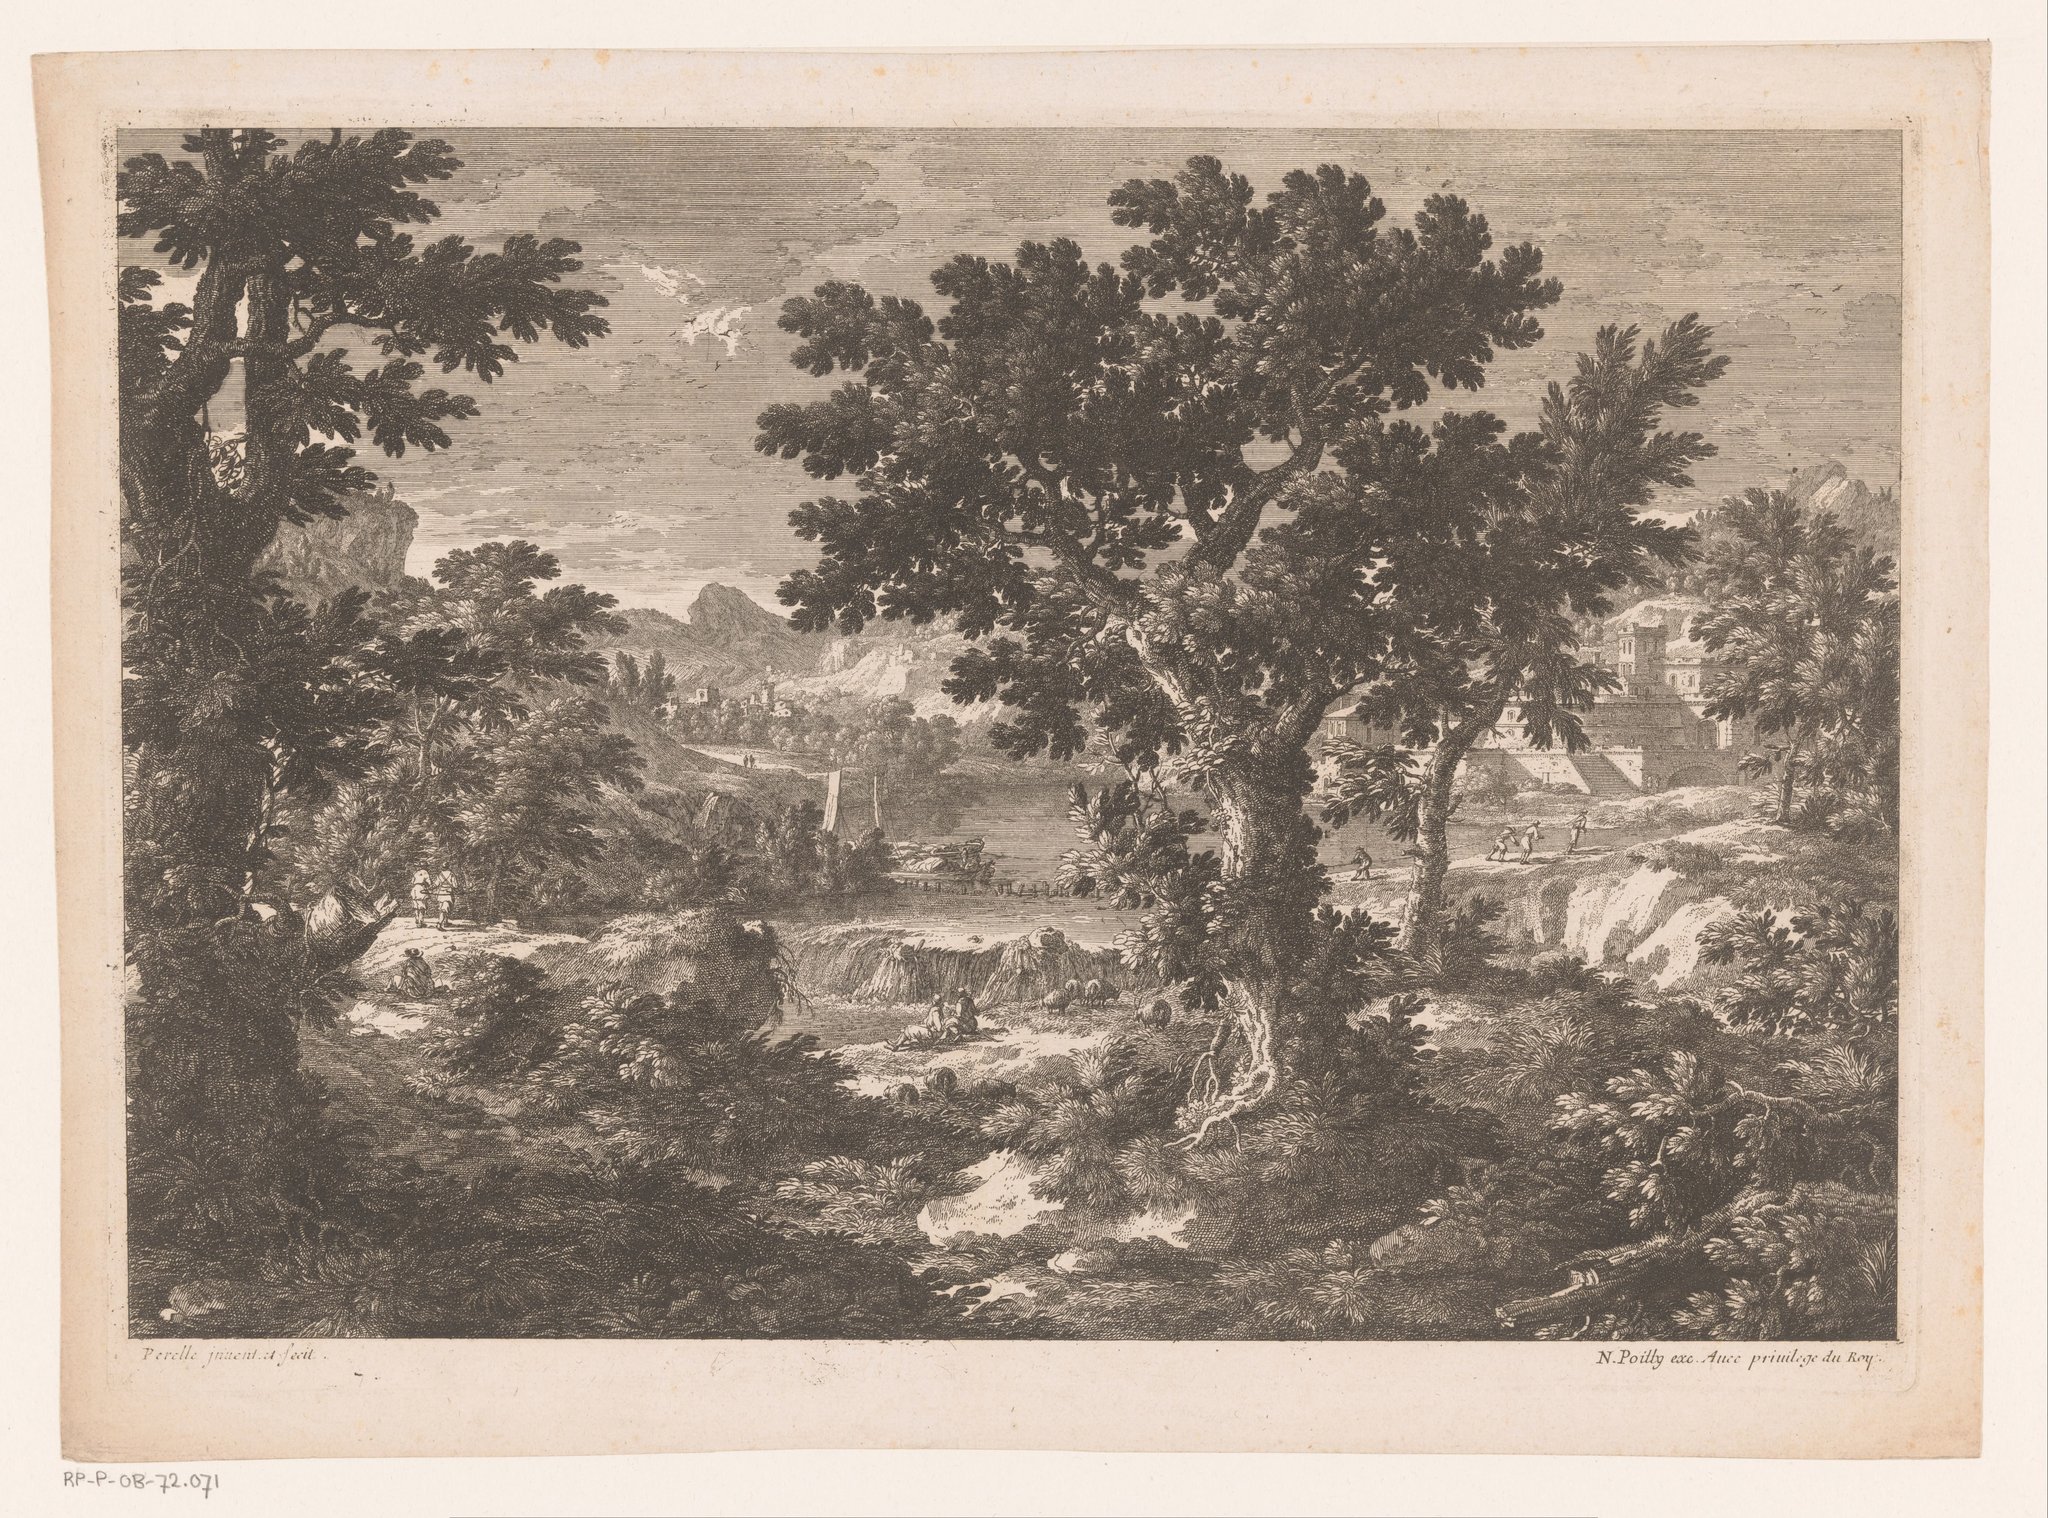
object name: print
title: Rivierlandschap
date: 1636-1695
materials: paper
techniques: engraving, etching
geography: france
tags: prospect of village, silhouette of village, river (+ landscape with figures, staffage), herd, flock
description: Prenten met het signatuur 'Perelle' kunnen zowel door vader Gabriel als door zonen Nicolas en Adam gemaakt zijn.